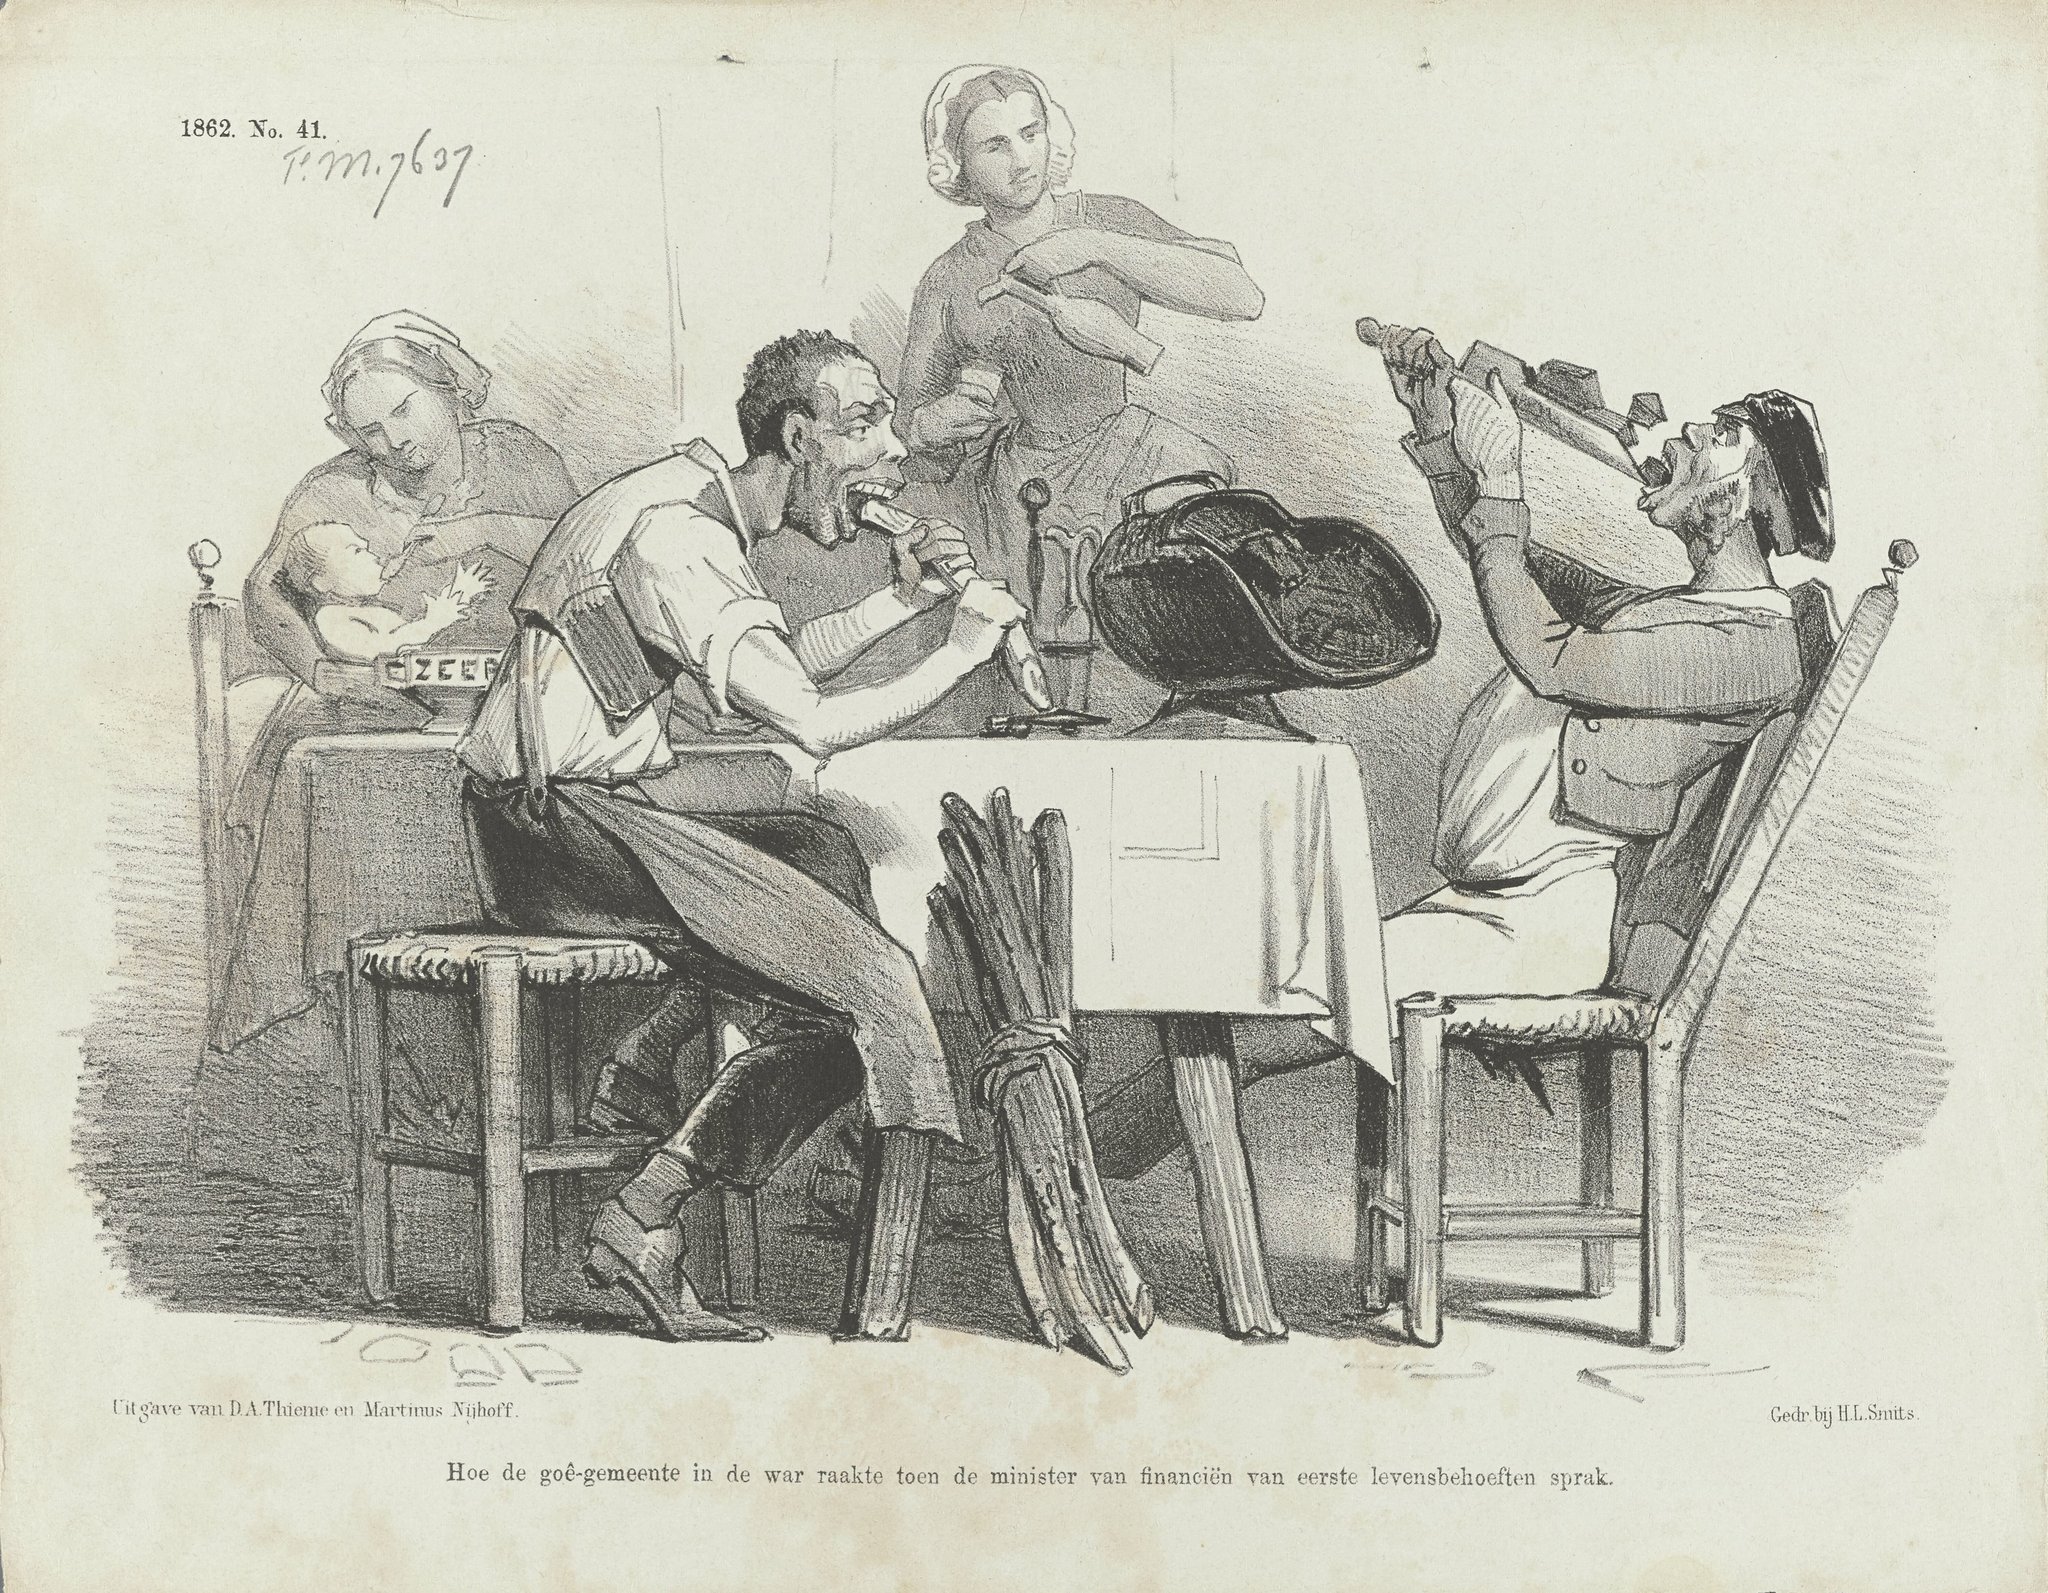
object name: cartoon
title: Spotprent op de afschaffing van accijnzen op brandstof en zeep, 1862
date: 1862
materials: paper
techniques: lithograph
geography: the hague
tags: coal-shovel, soap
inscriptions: collector's mark: Lugt 2228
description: Spotprent op de afschaffing van accijnzen op brandstof en zeep. Een gezin aan tafel hout, kolen en zeep etend. Plaat verschenen bij het weekblad De Nederlandsche Spectator, nr. 41, 10 oktober 1862.